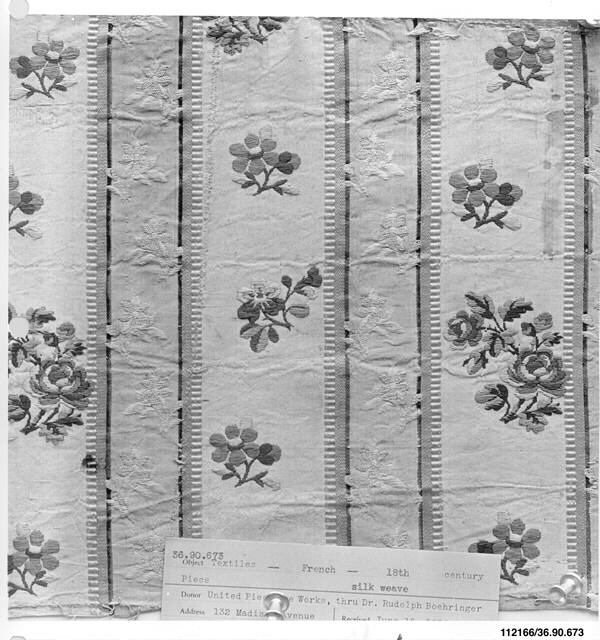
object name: piece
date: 1701-1800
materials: silk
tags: flowers,leaves